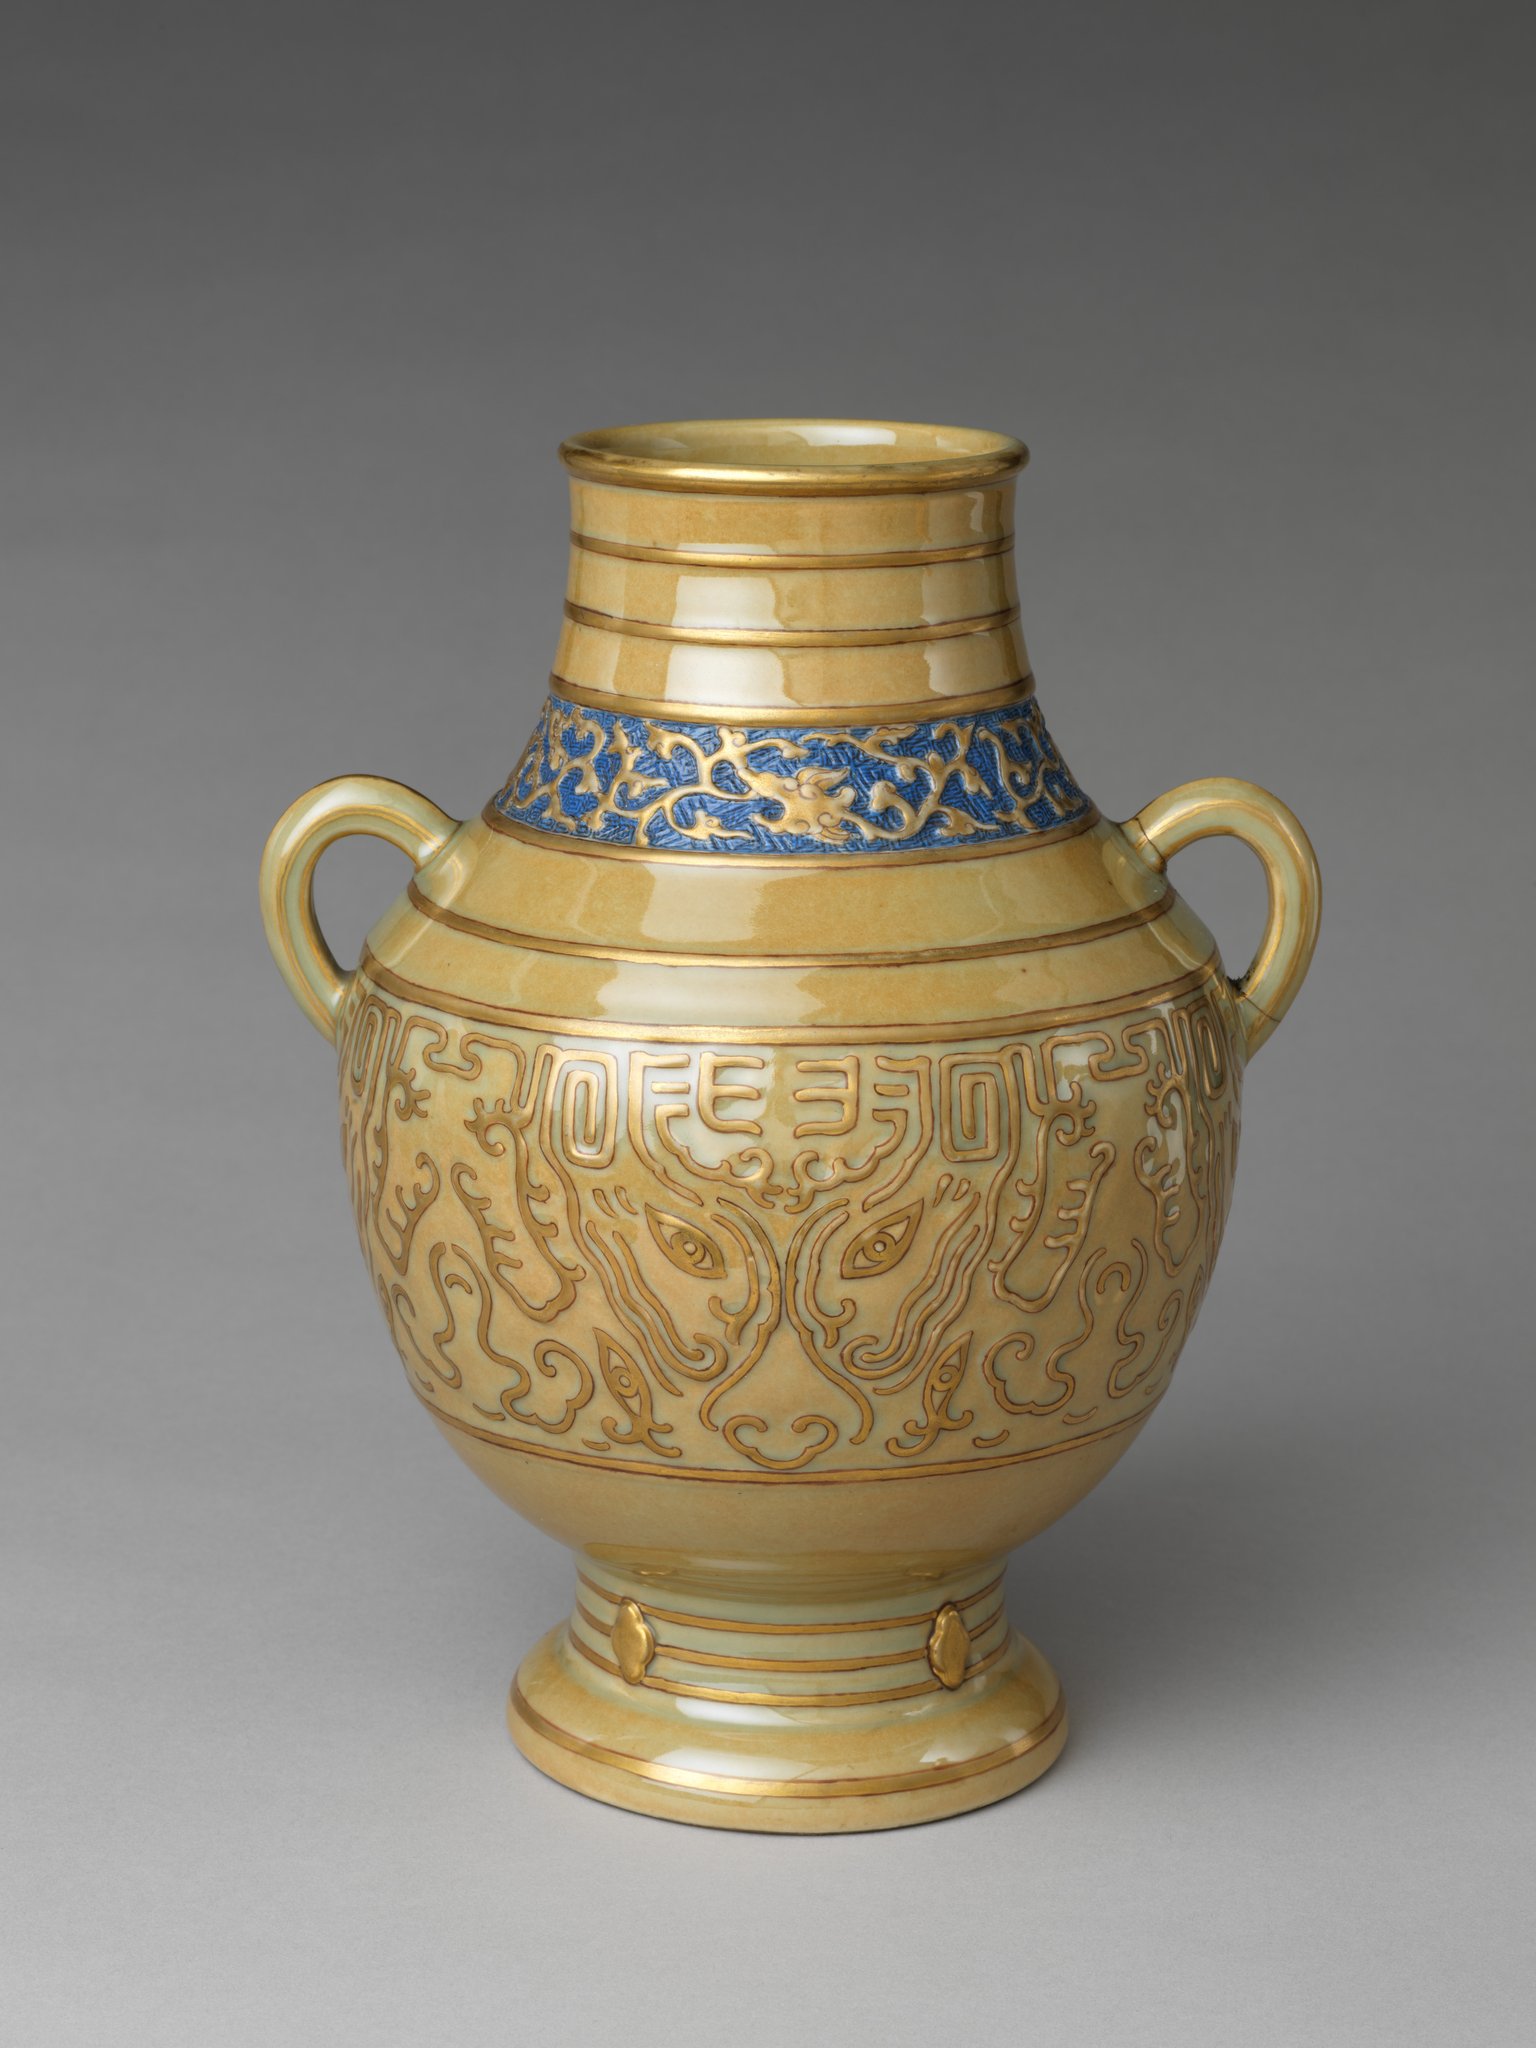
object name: vase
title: Vase in the form of an archaic bronze vessel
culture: chinese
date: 1734-1766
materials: gilt, glaze, porcelain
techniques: relief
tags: eyes